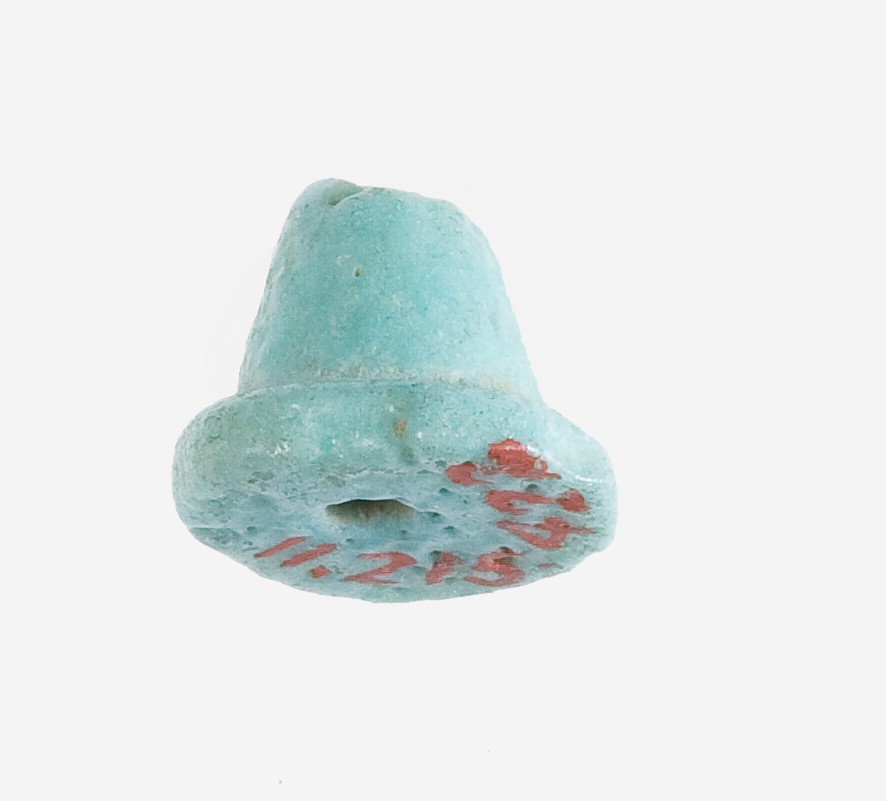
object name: pendant, umbel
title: Umbel Pendant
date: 1390-1352 BCE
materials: faience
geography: egypt